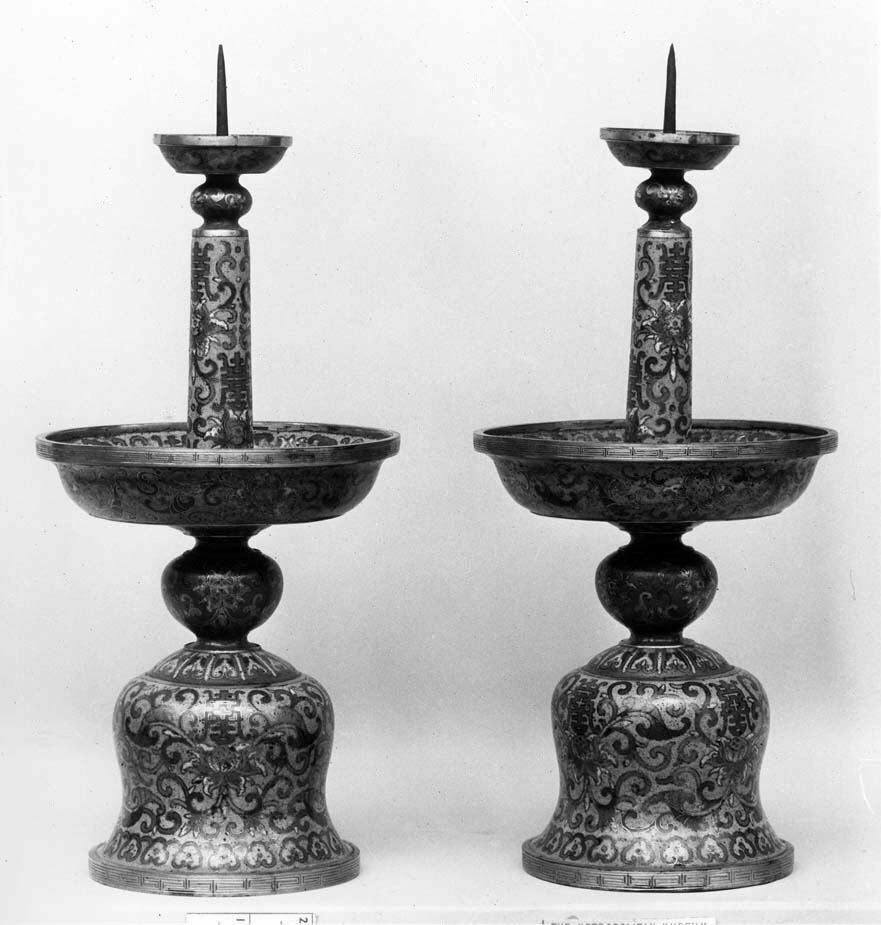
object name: candlestick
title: Candlestick from a Set of Five-Piece Altar Set (Wugong)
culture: chinese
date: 1736-1795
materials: copper, enamel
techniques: enamel